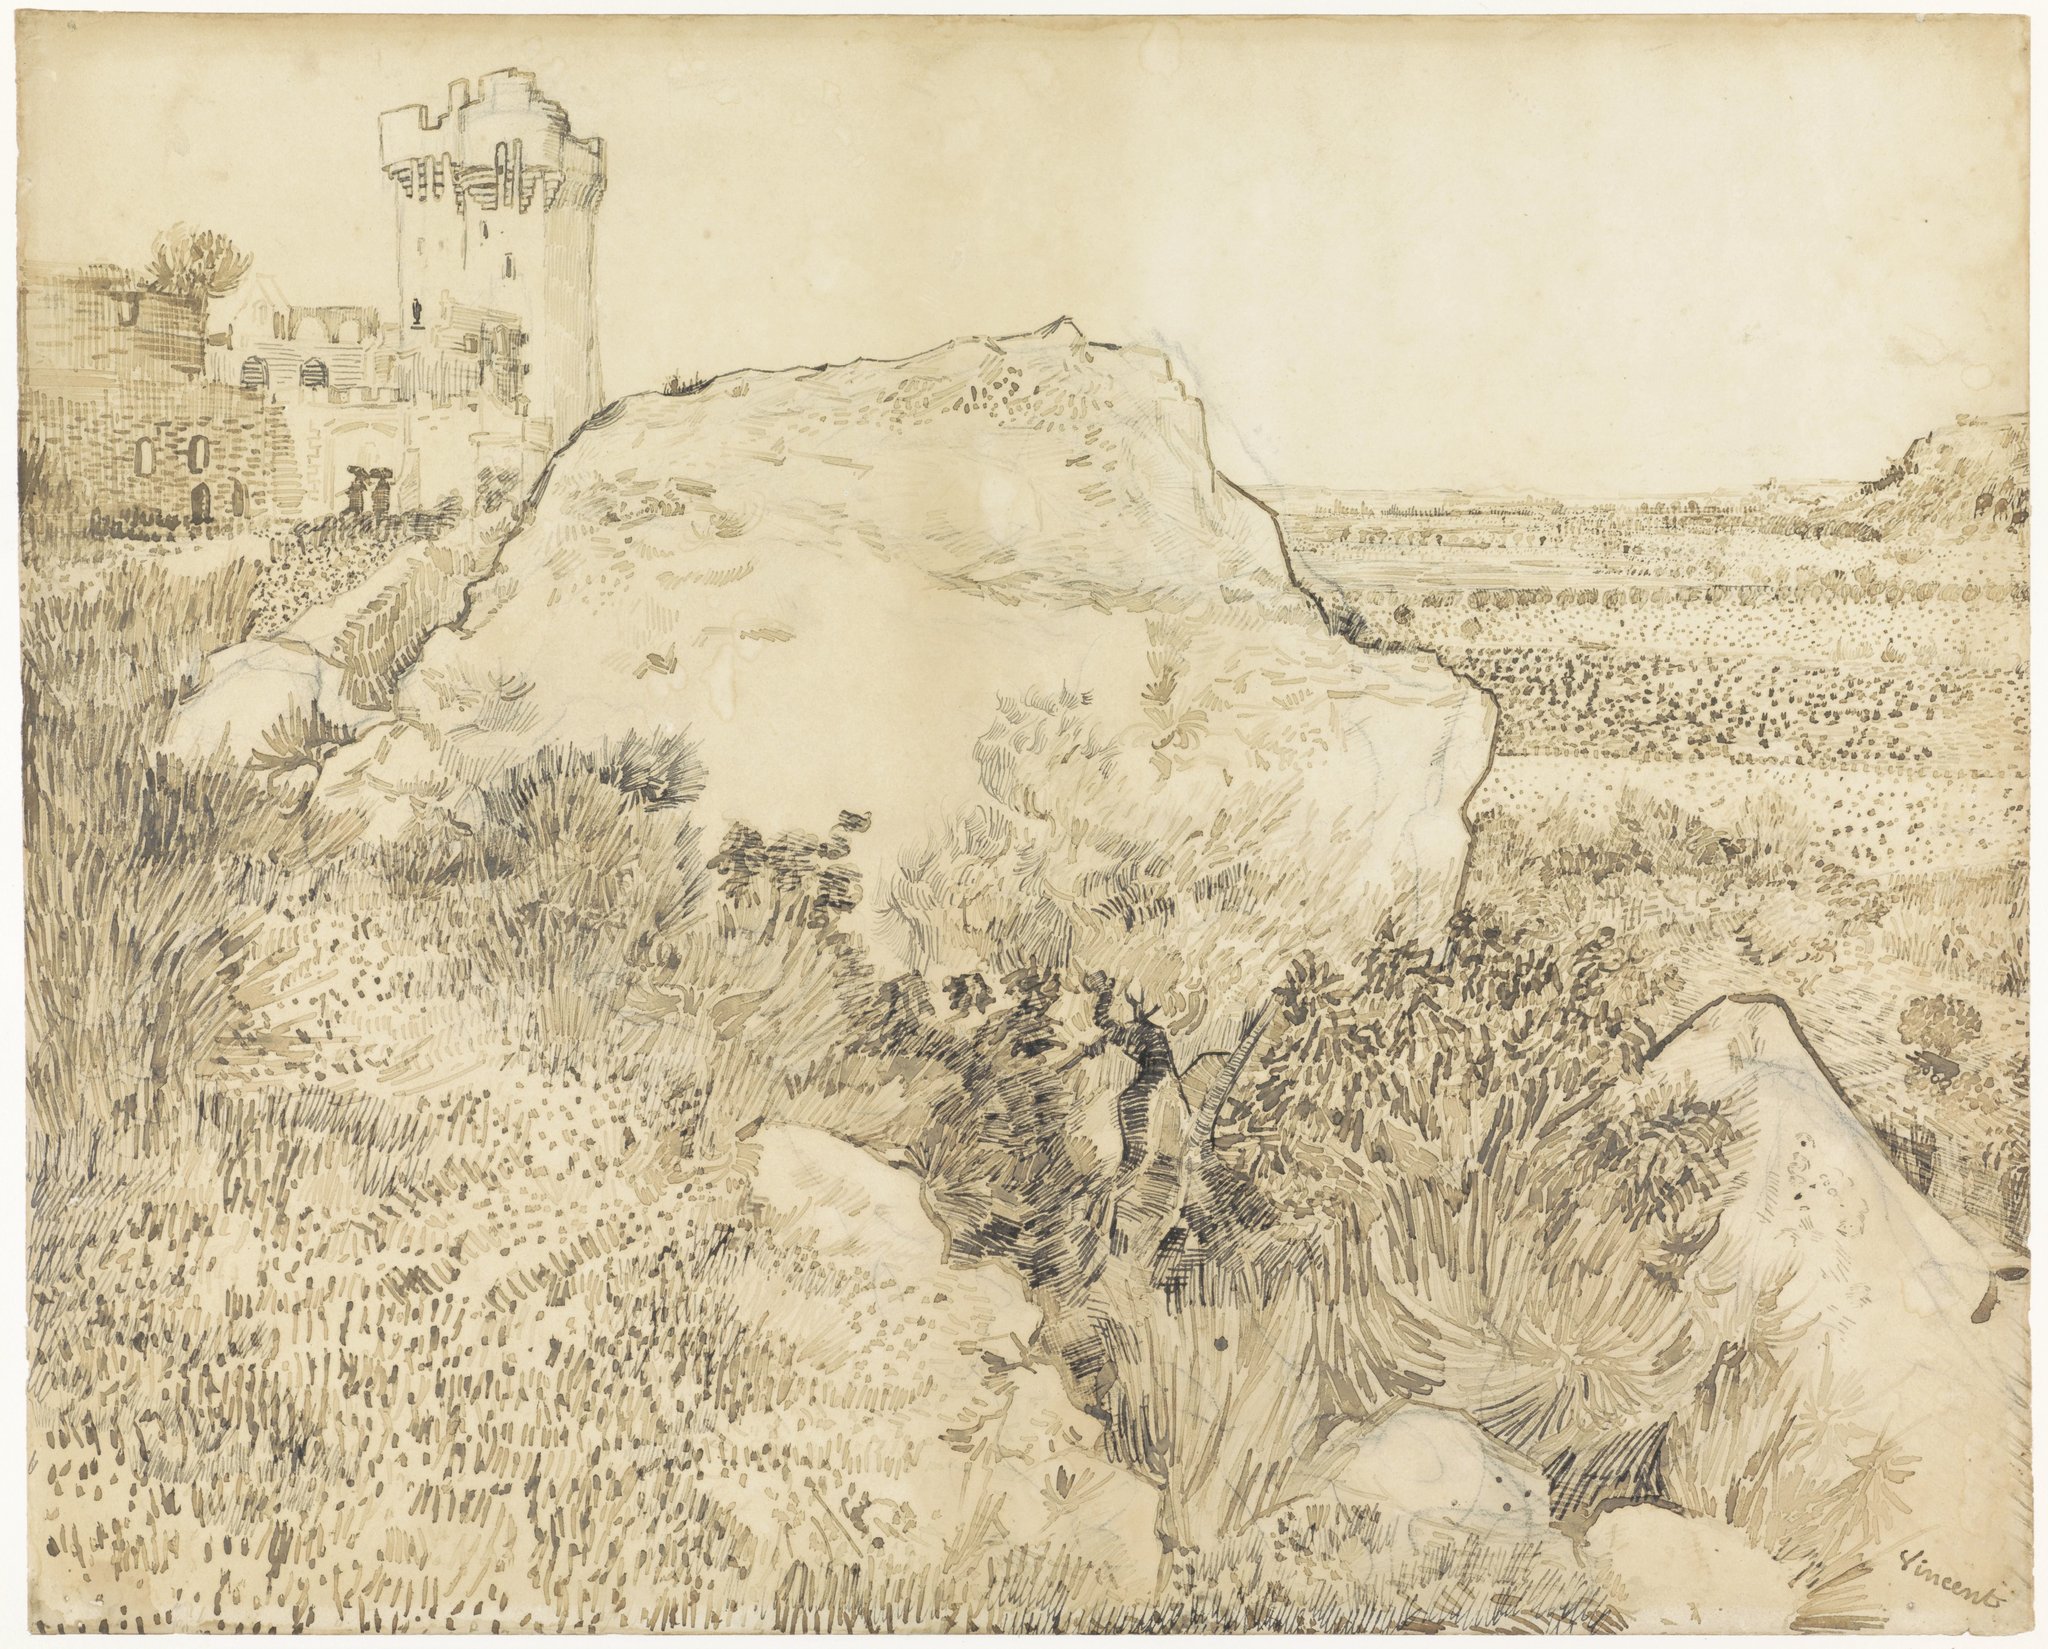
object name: drawing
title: Hill with the ruins of Montmajour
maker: vincent van gogh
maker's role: draughtsman, painter, print maker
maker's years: 1853-1890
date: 1888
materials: chalk, ink, paper, pencil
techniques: pen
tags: abbey, monastery, convent ~ roman catholic church, plain